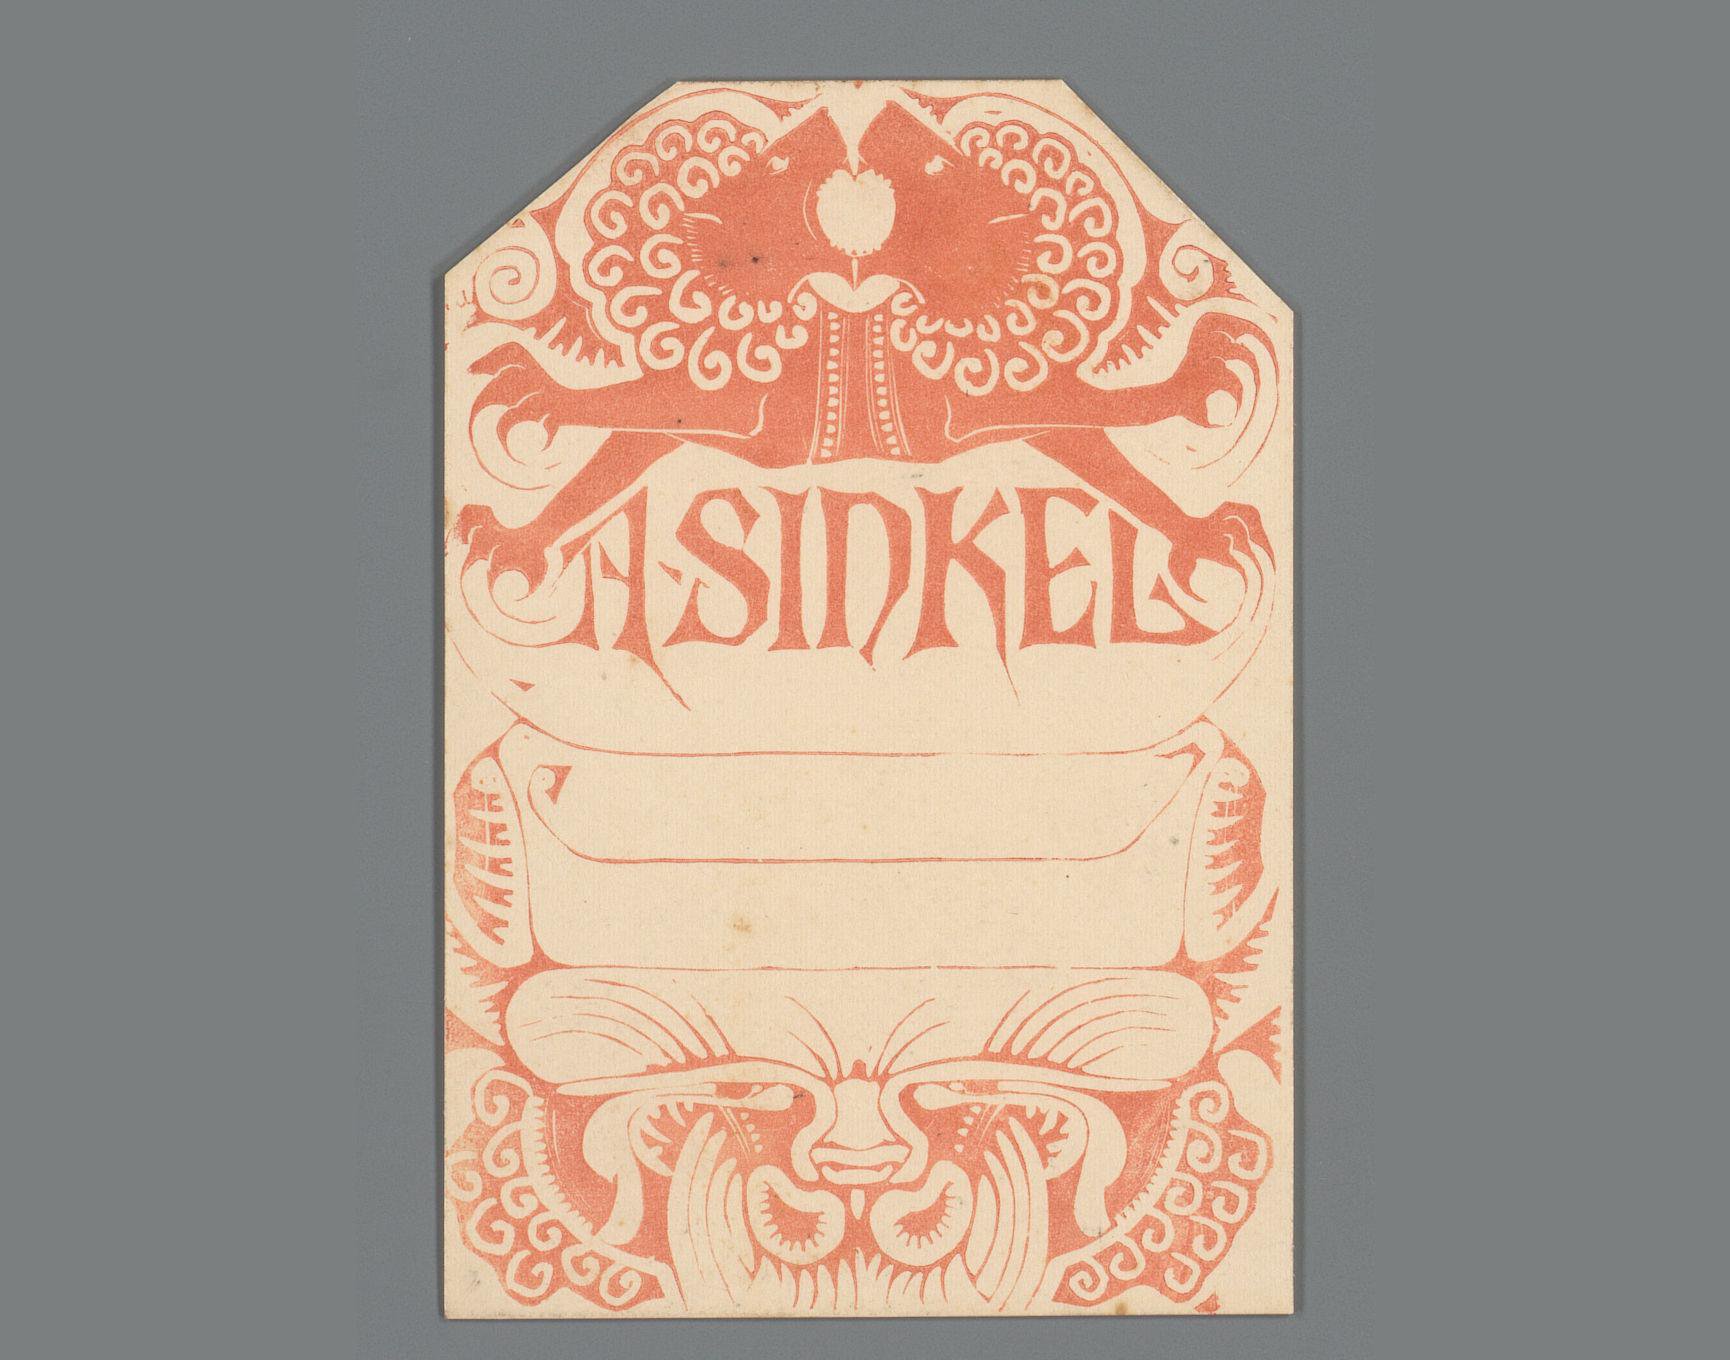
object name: print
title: Etiket van A. Sinkel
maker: mathieu lauweriks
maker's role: designer, draughtsman, print maker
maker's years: 1864-1932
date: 1874-1932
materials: paper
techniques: woodcut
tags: mask, insects: butterfly, beasts of prey, predatory animals: lion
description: Bovenaan twee leeuwen, onderaan een vlinder of masker.